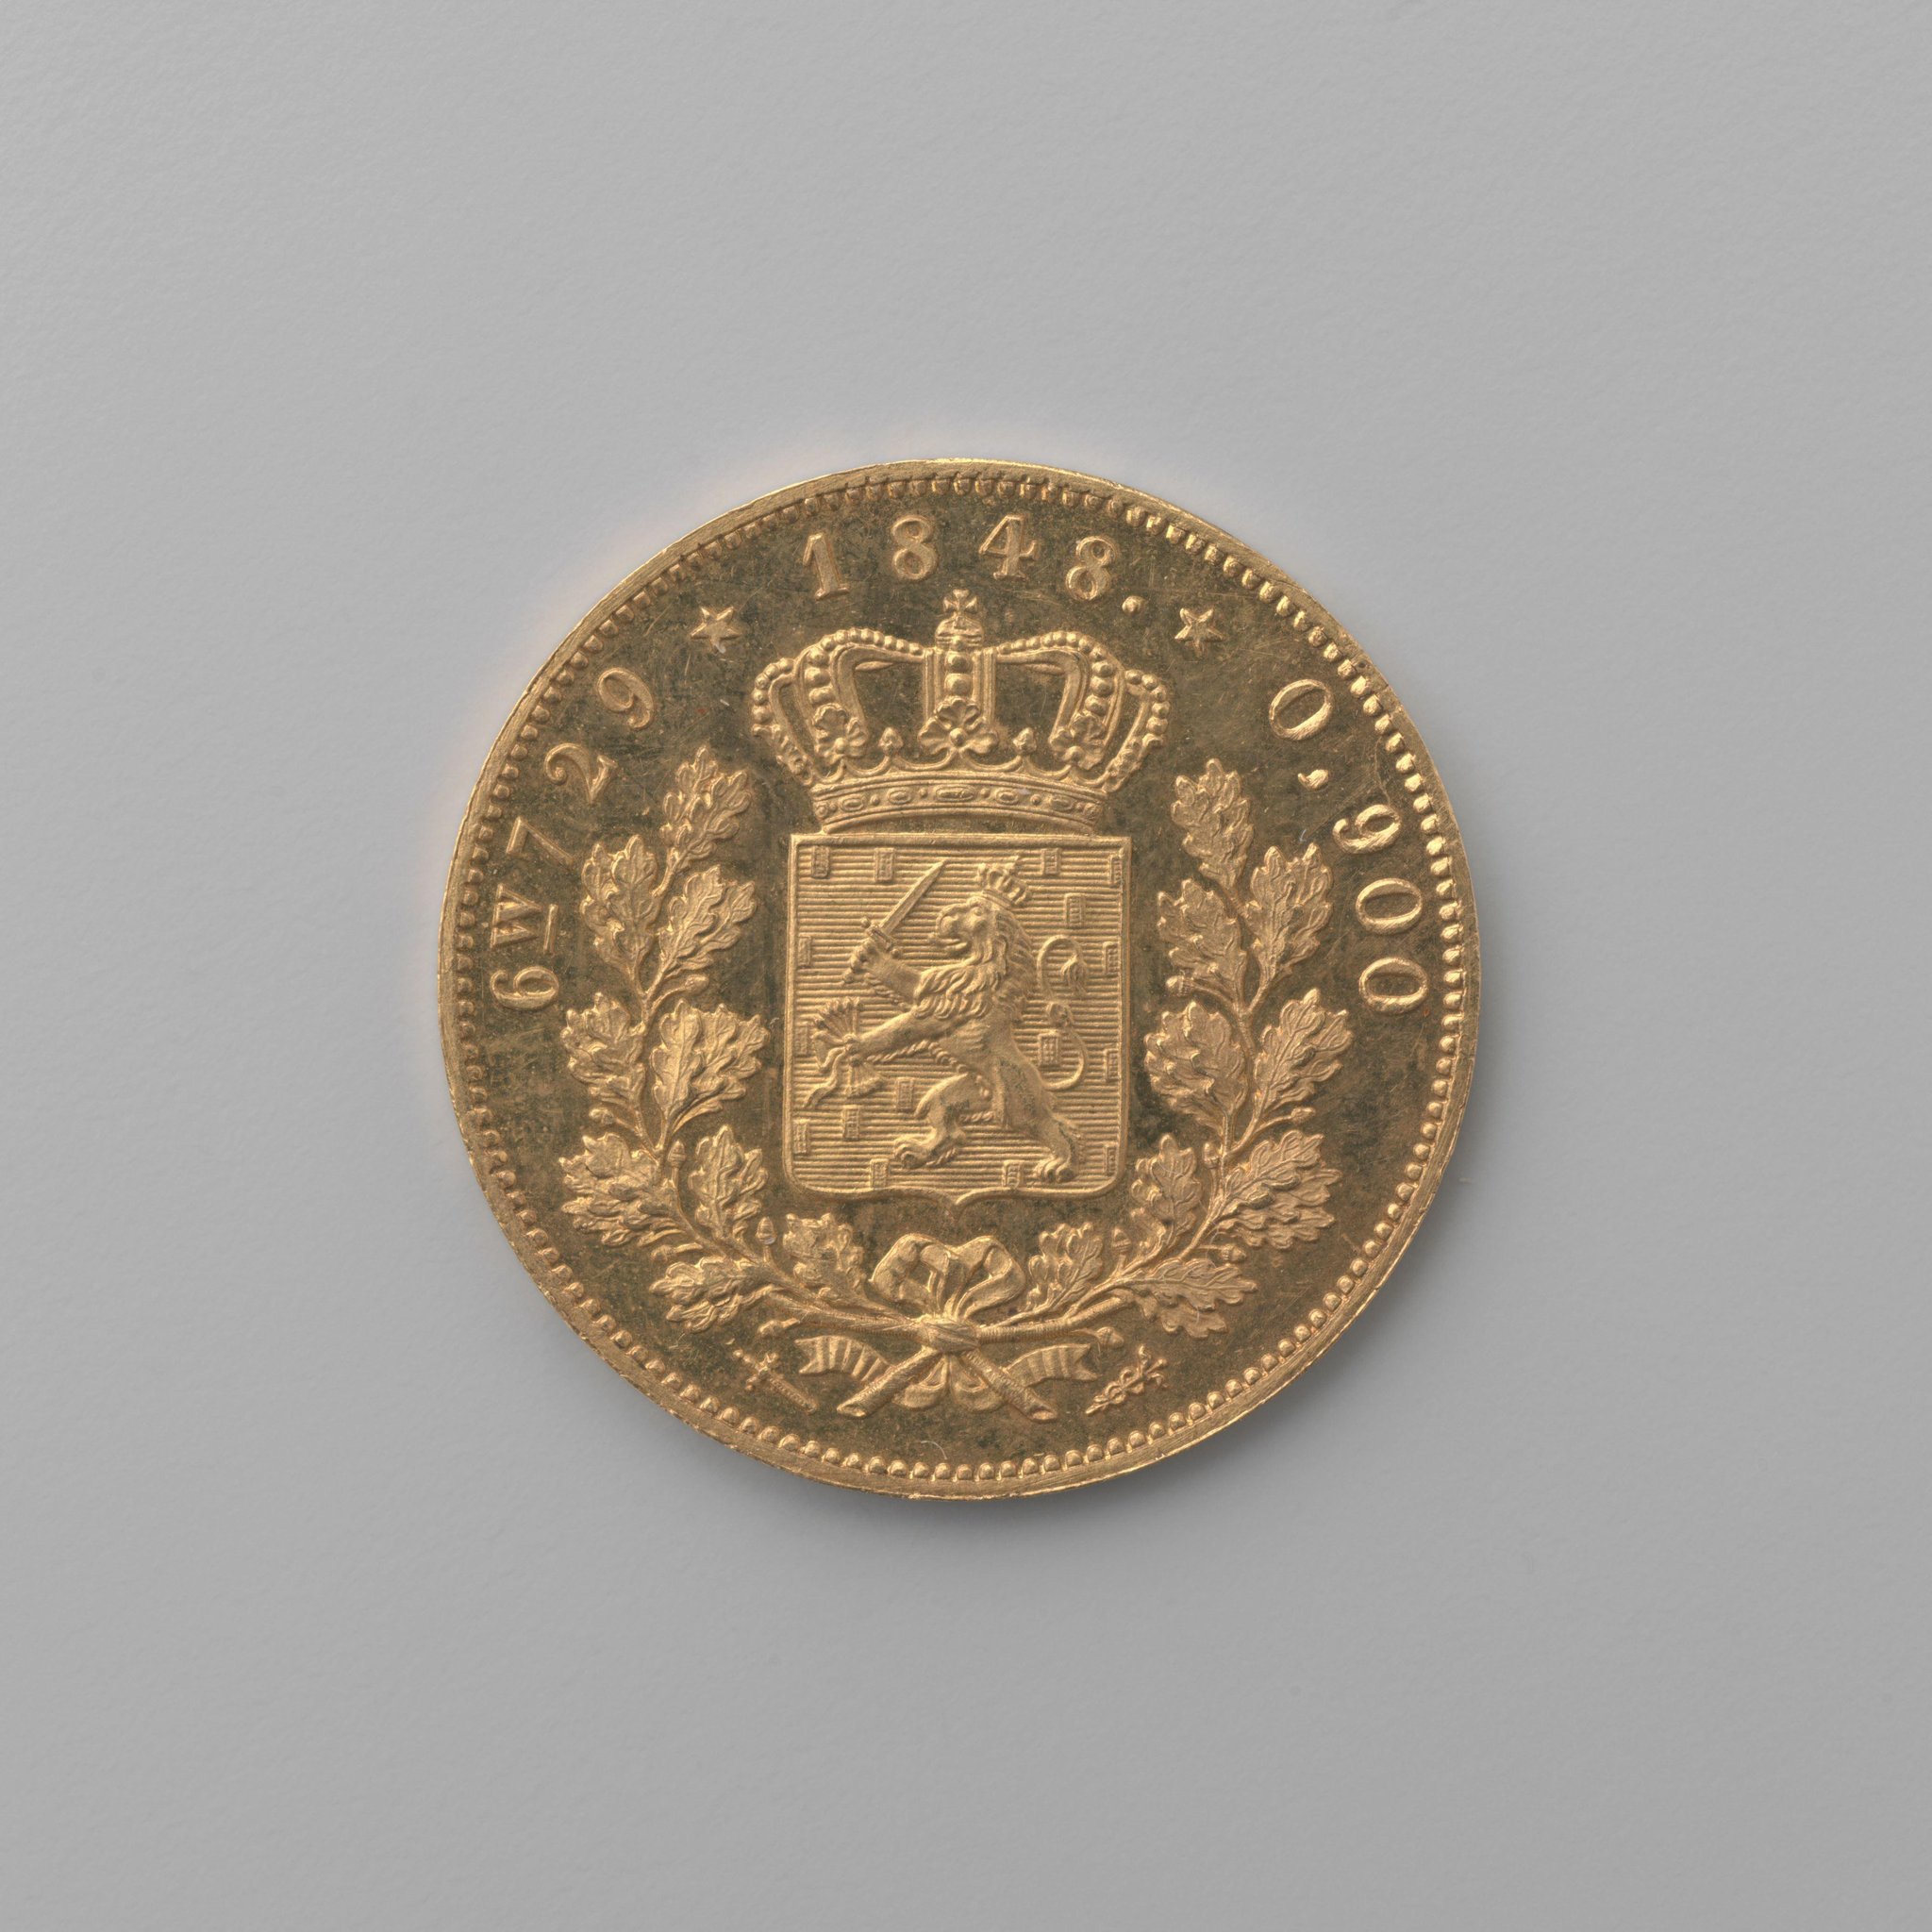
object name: willem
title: Nederlandse negotiepenning of enkele Willem, 1848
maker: william ii of the netherlands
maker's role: koning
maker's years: 1792-1849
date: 1848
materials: gold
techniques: striking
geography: utrecht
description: Gouden munt. Voorzijde: borstbeeld naar rechts. Keerzijde: tussen twee samengebonden eiketakken gekroond rijkswapenschild. Omschrift: Jaartal, boven kroon, gewicht- en gehalte-aanduiding. Randschrift.